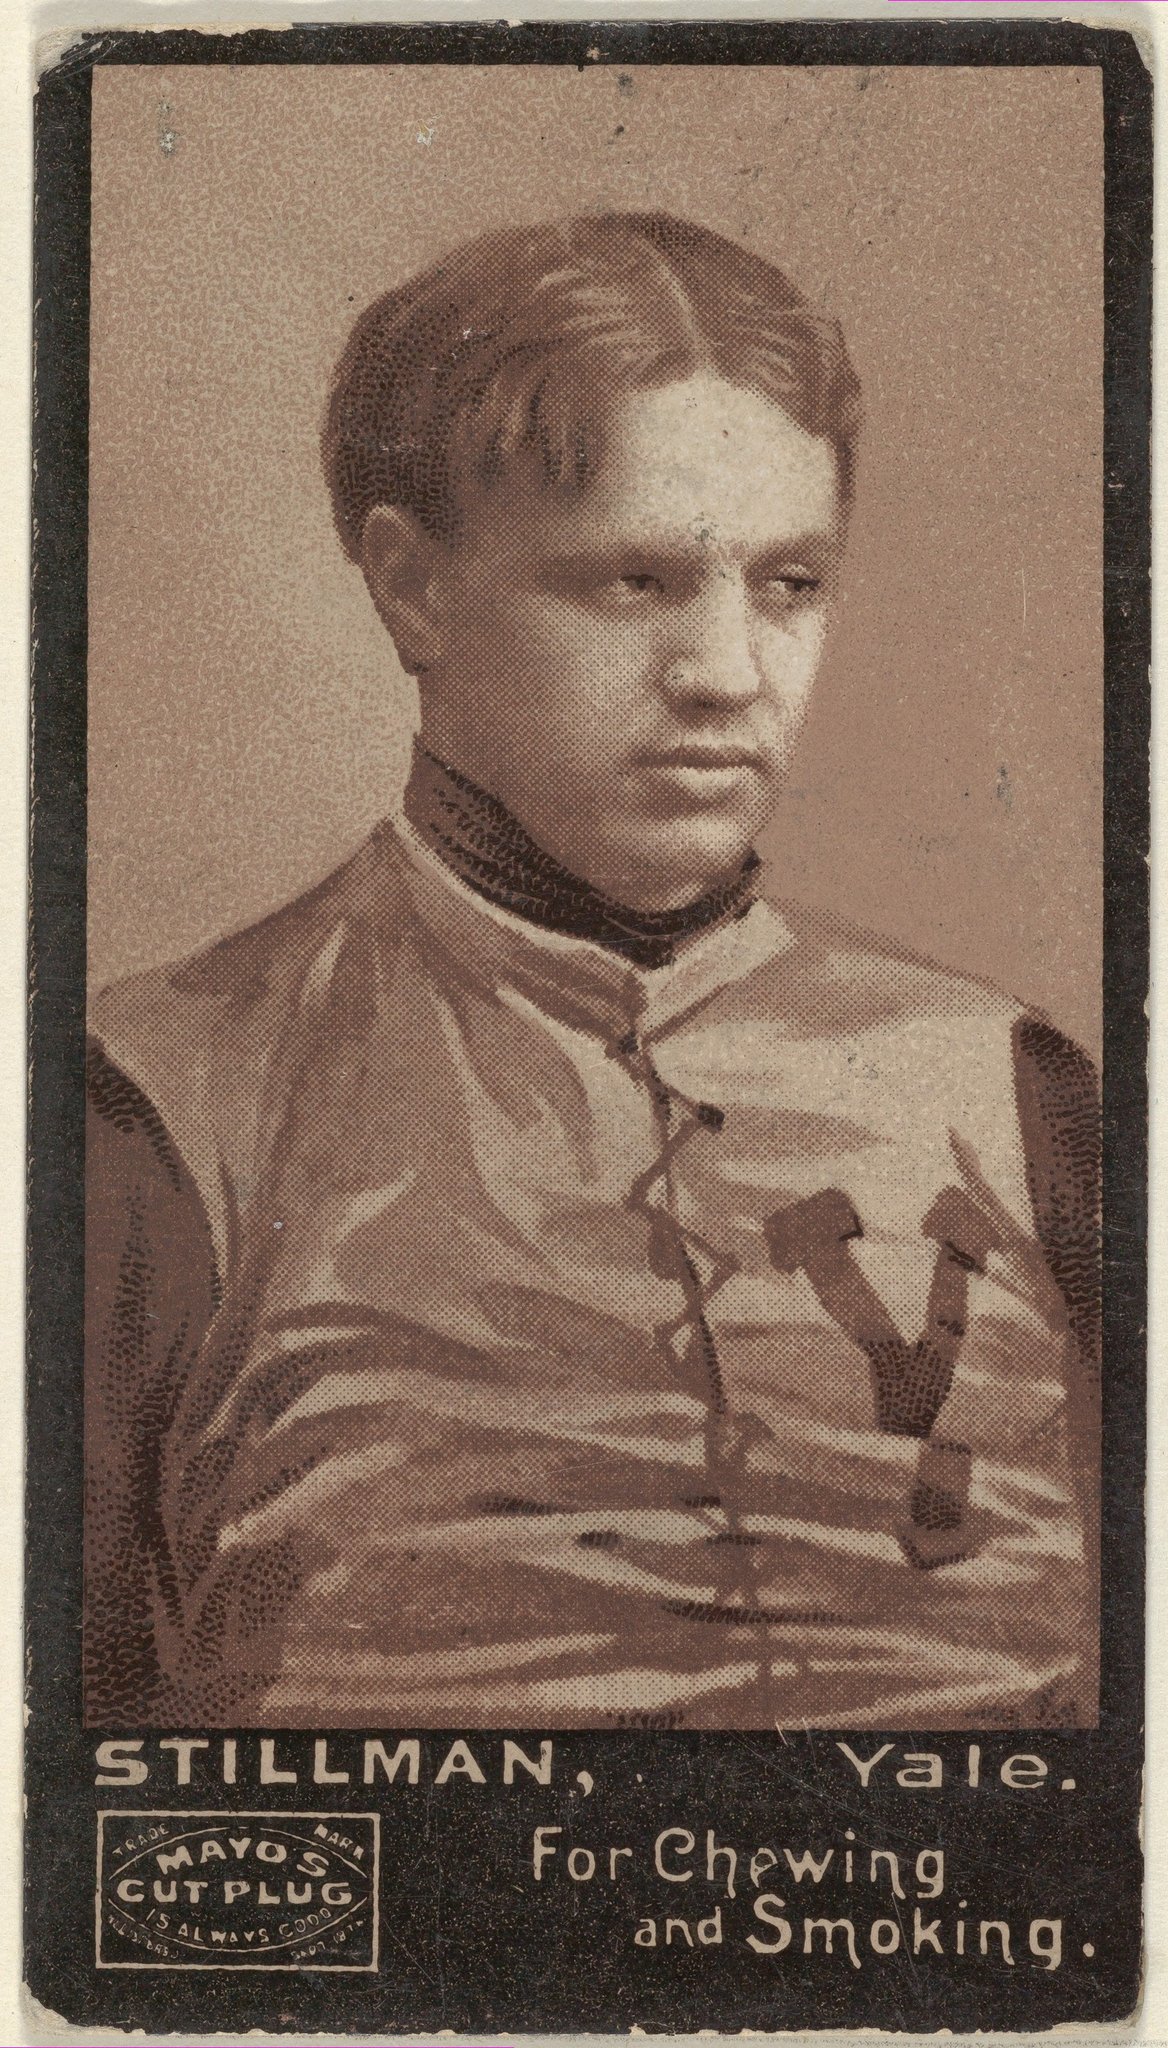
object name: print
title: Stillman, Yale University, from the College Football Stars series (N302) for Mayo's Cut Plug Tobacco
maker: p.h. mayo & brother, richmond, virginia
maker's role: publisher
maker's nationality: american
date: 1894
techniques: lithography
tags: men,portraits,football,athletes